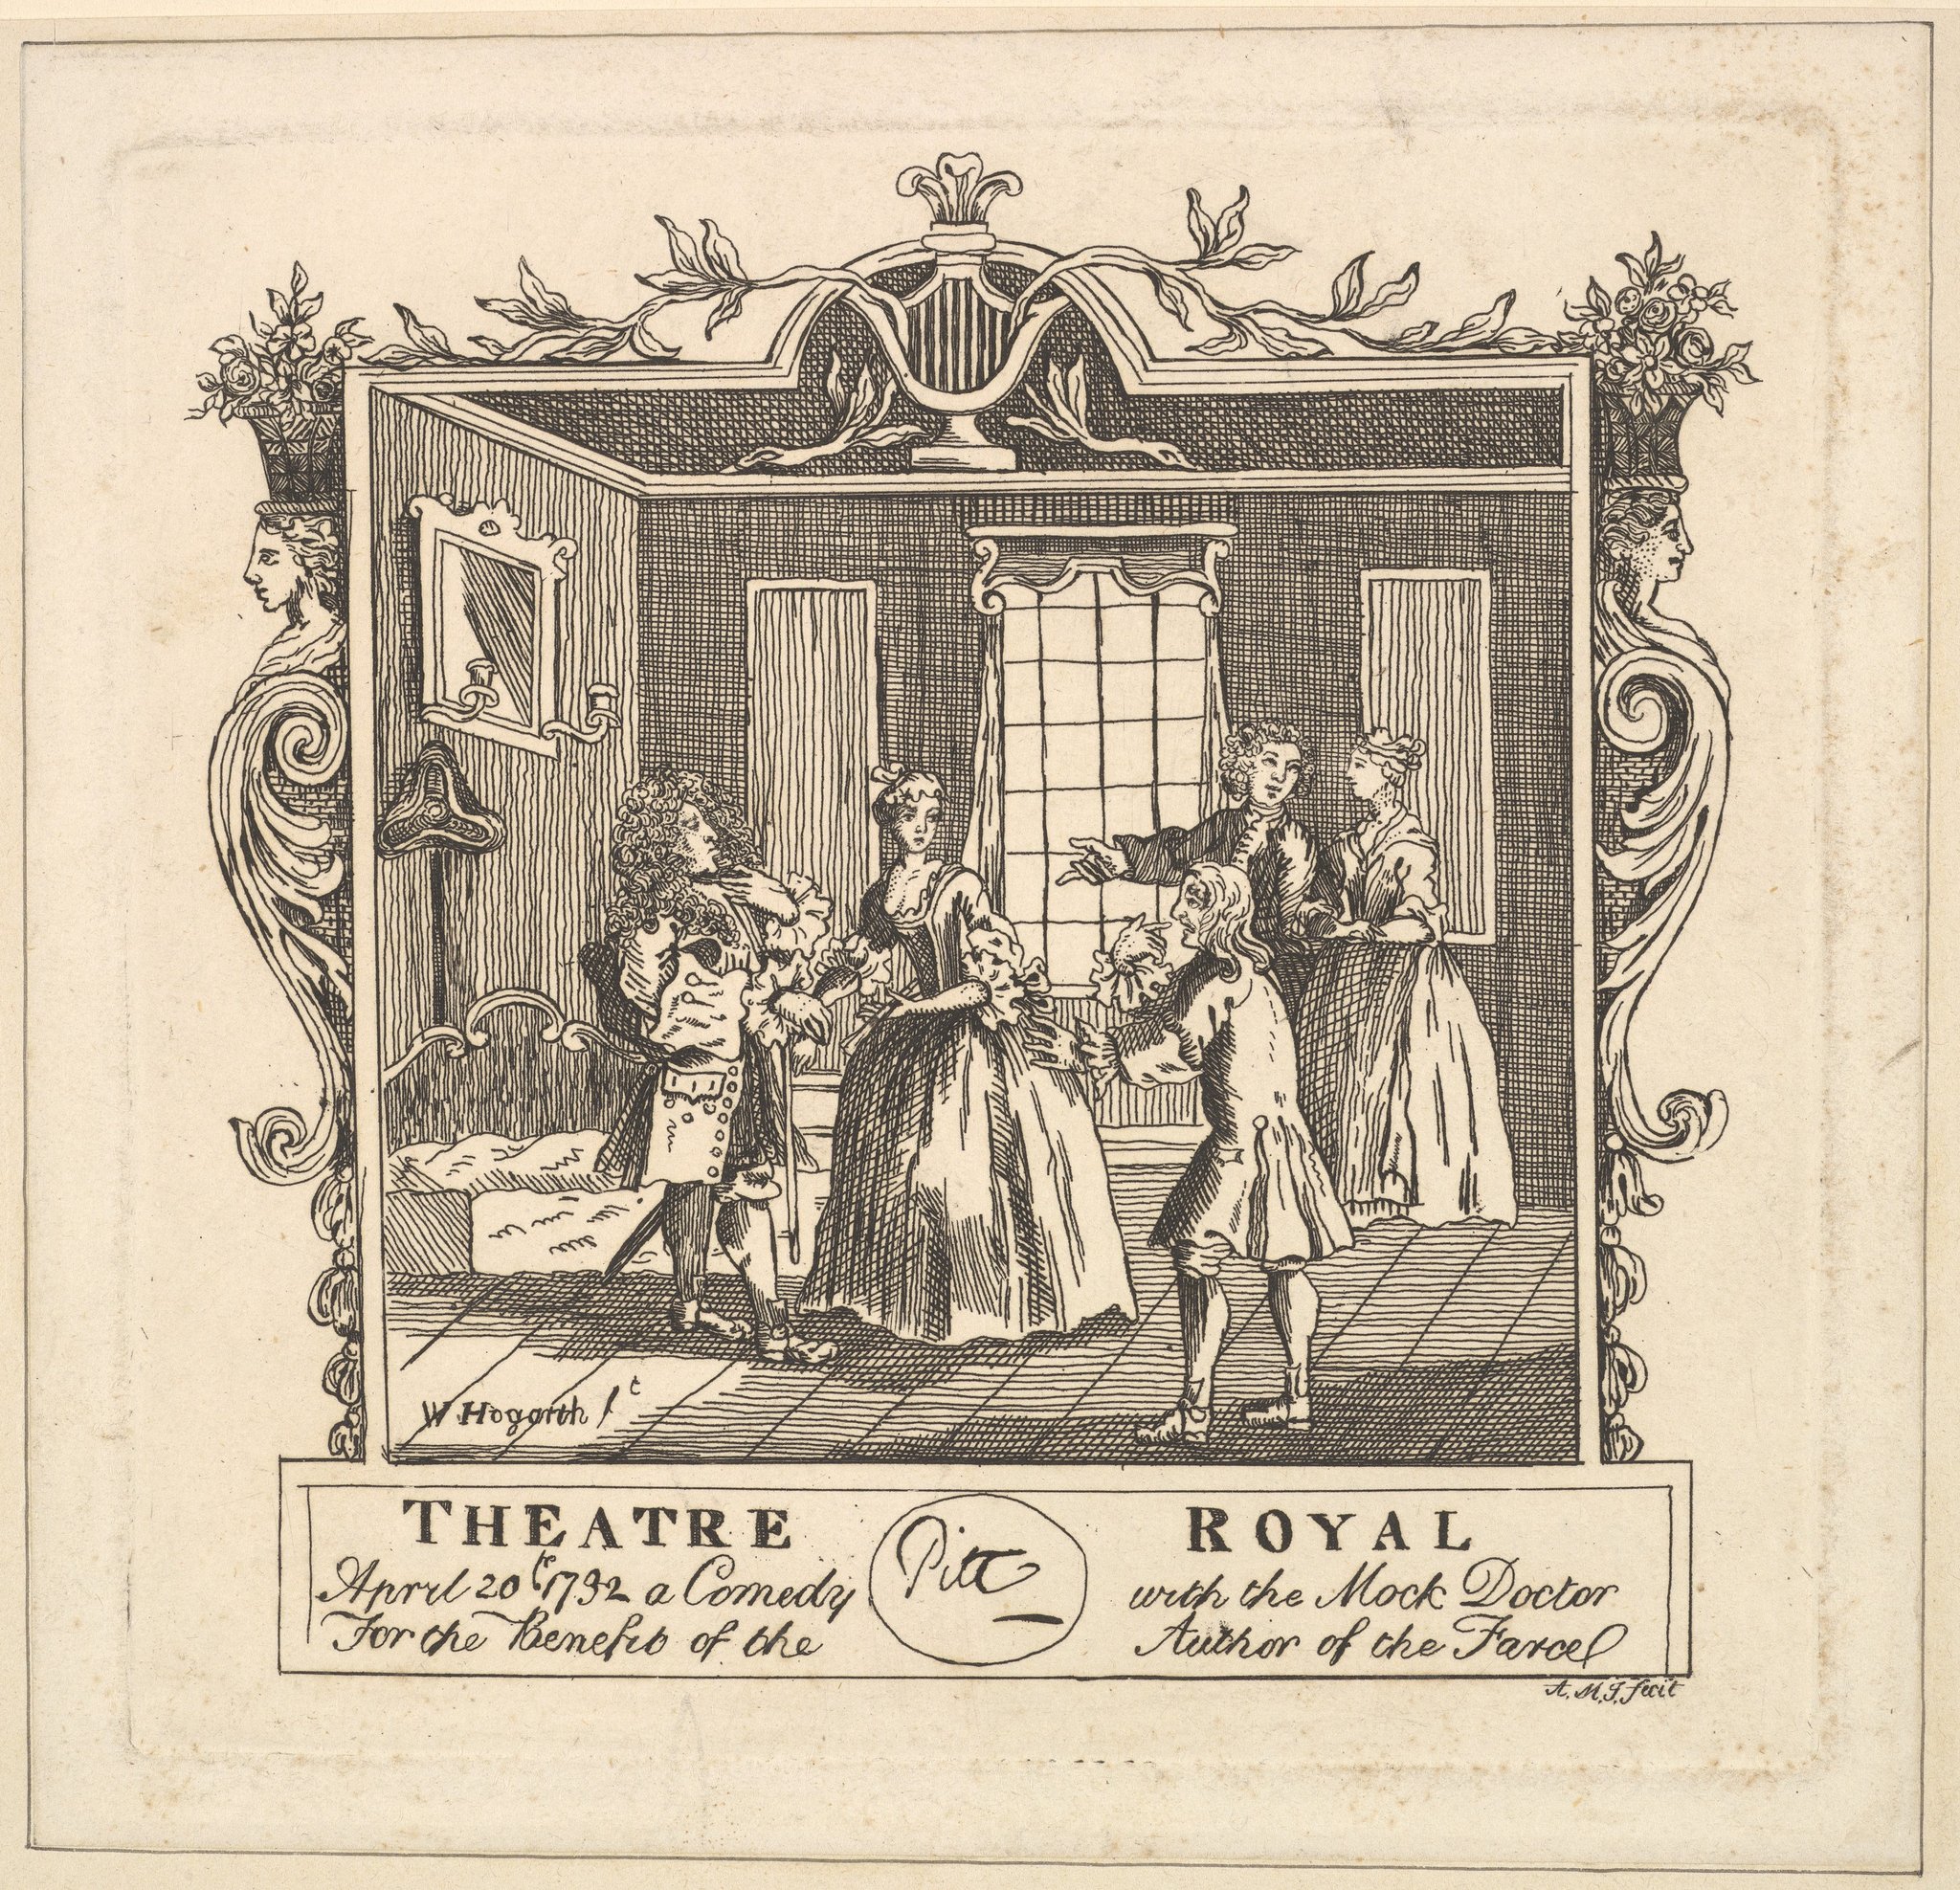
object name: print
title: Ticket for Henry Fielding's The Mock Doctor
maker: william hogarth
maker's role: artist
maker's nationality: british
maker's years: 1697-1764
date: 1792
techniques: etching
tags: theatre,men,women